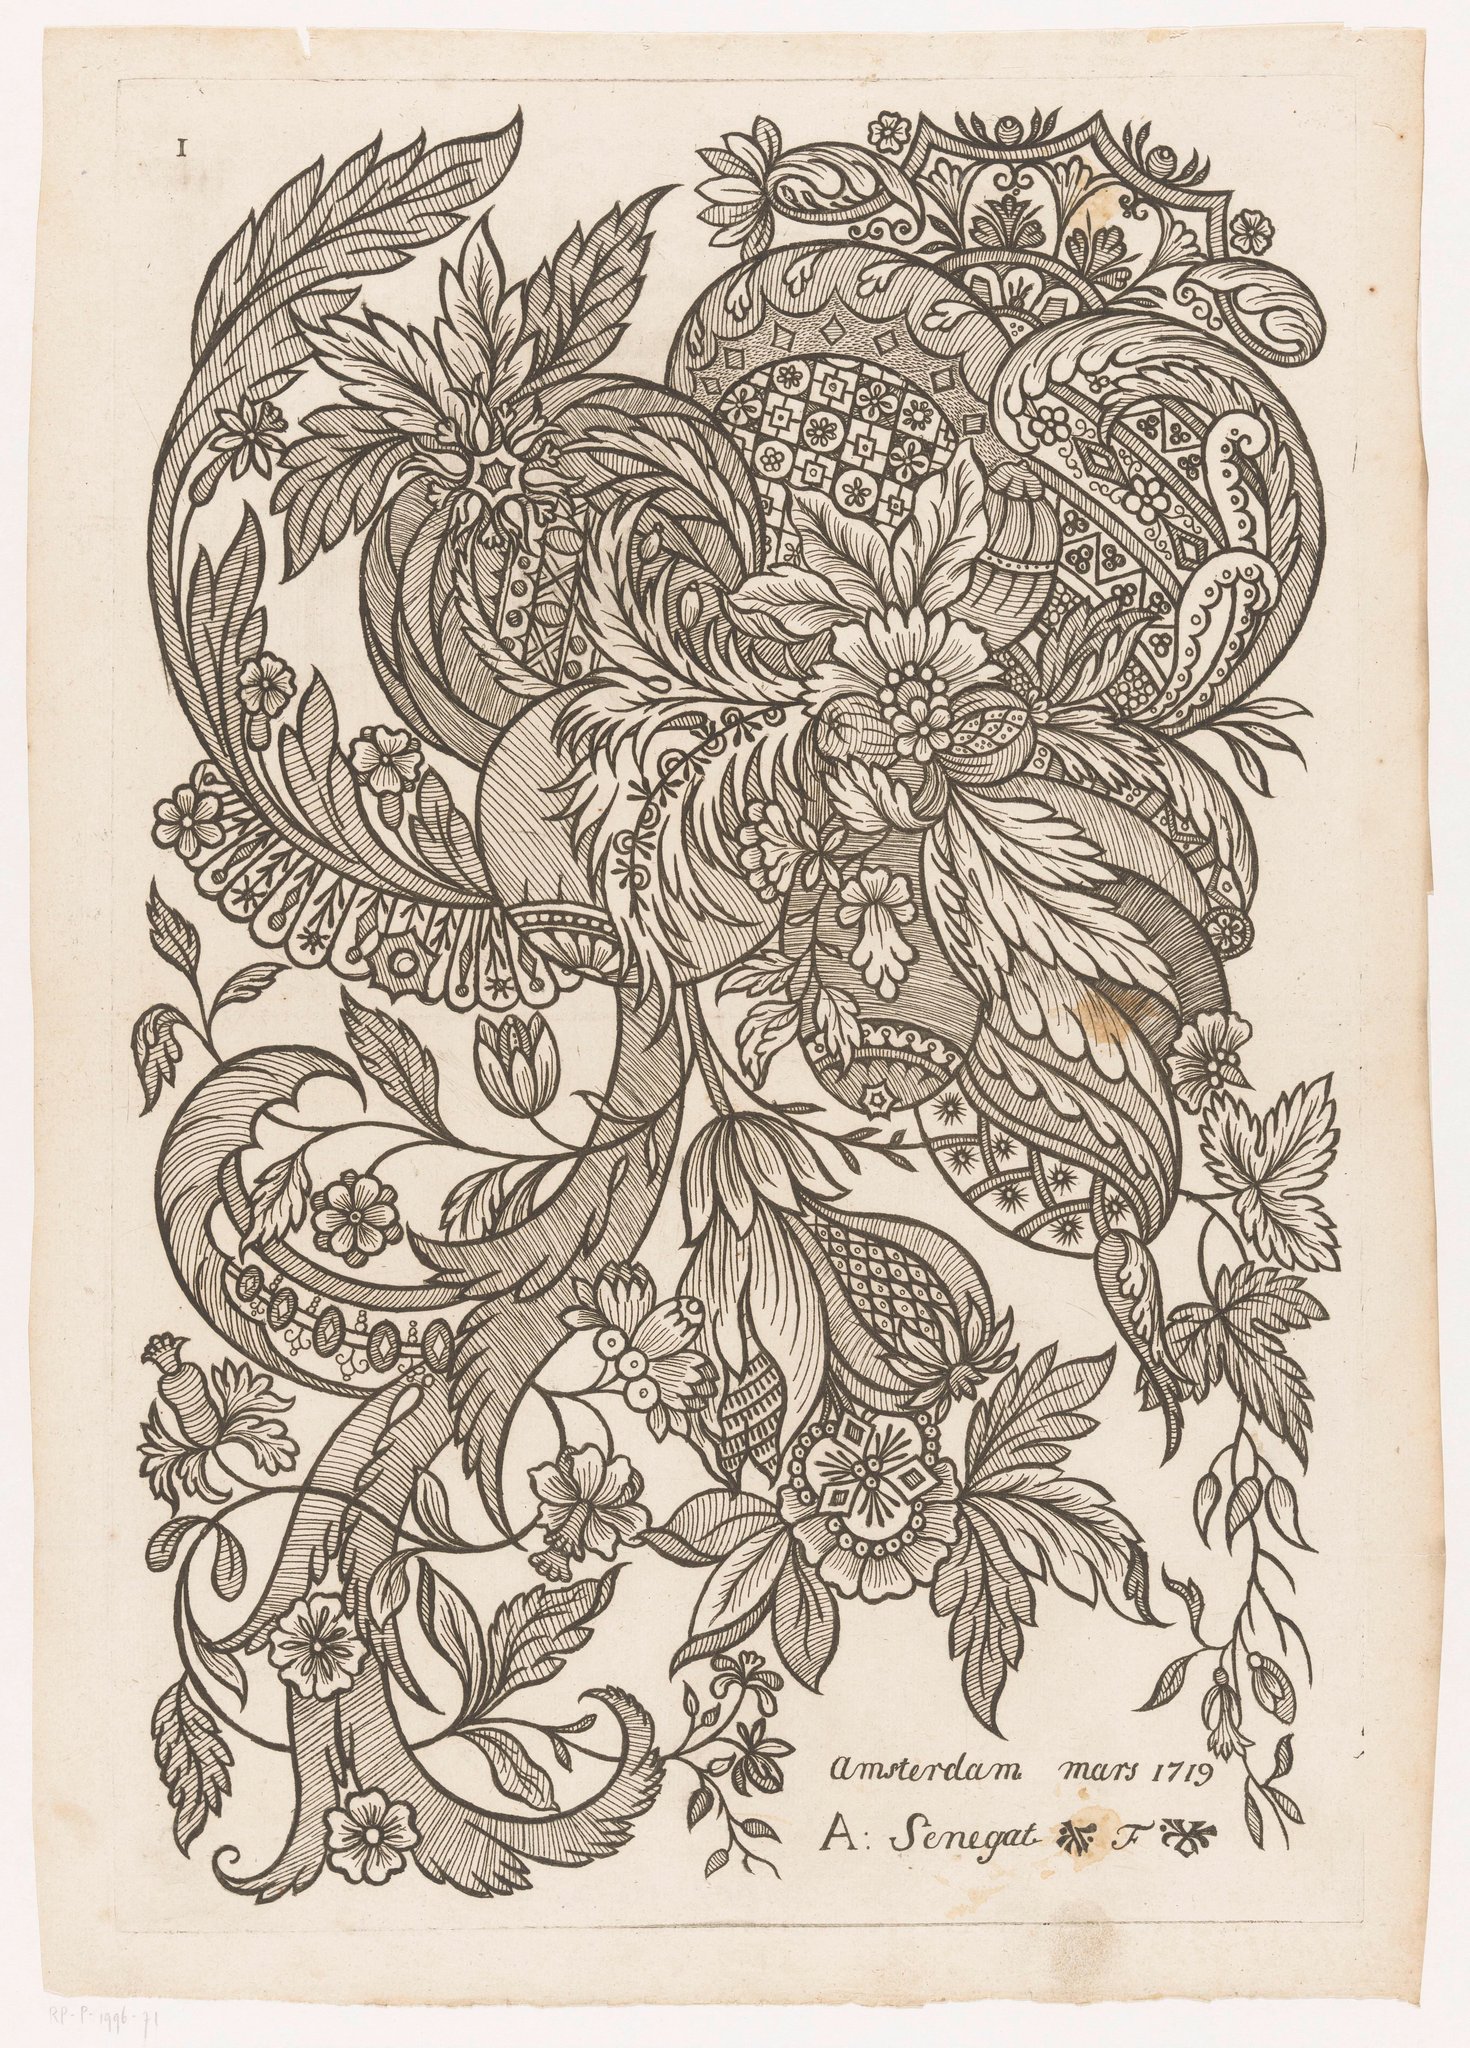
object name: ornament print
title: Ontwerp voor textiel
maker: alexander senegat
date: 1703-1719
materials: paper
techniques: etching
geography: amsterdam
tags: artist (in general) making preliminary designs, sketching, textile industry and clothing industry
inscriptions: collector's mark: Lugt 2760, collector's mark: Lugt 2228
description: Ontwerp voor textiel met fantasiebloemen en -bladeren.